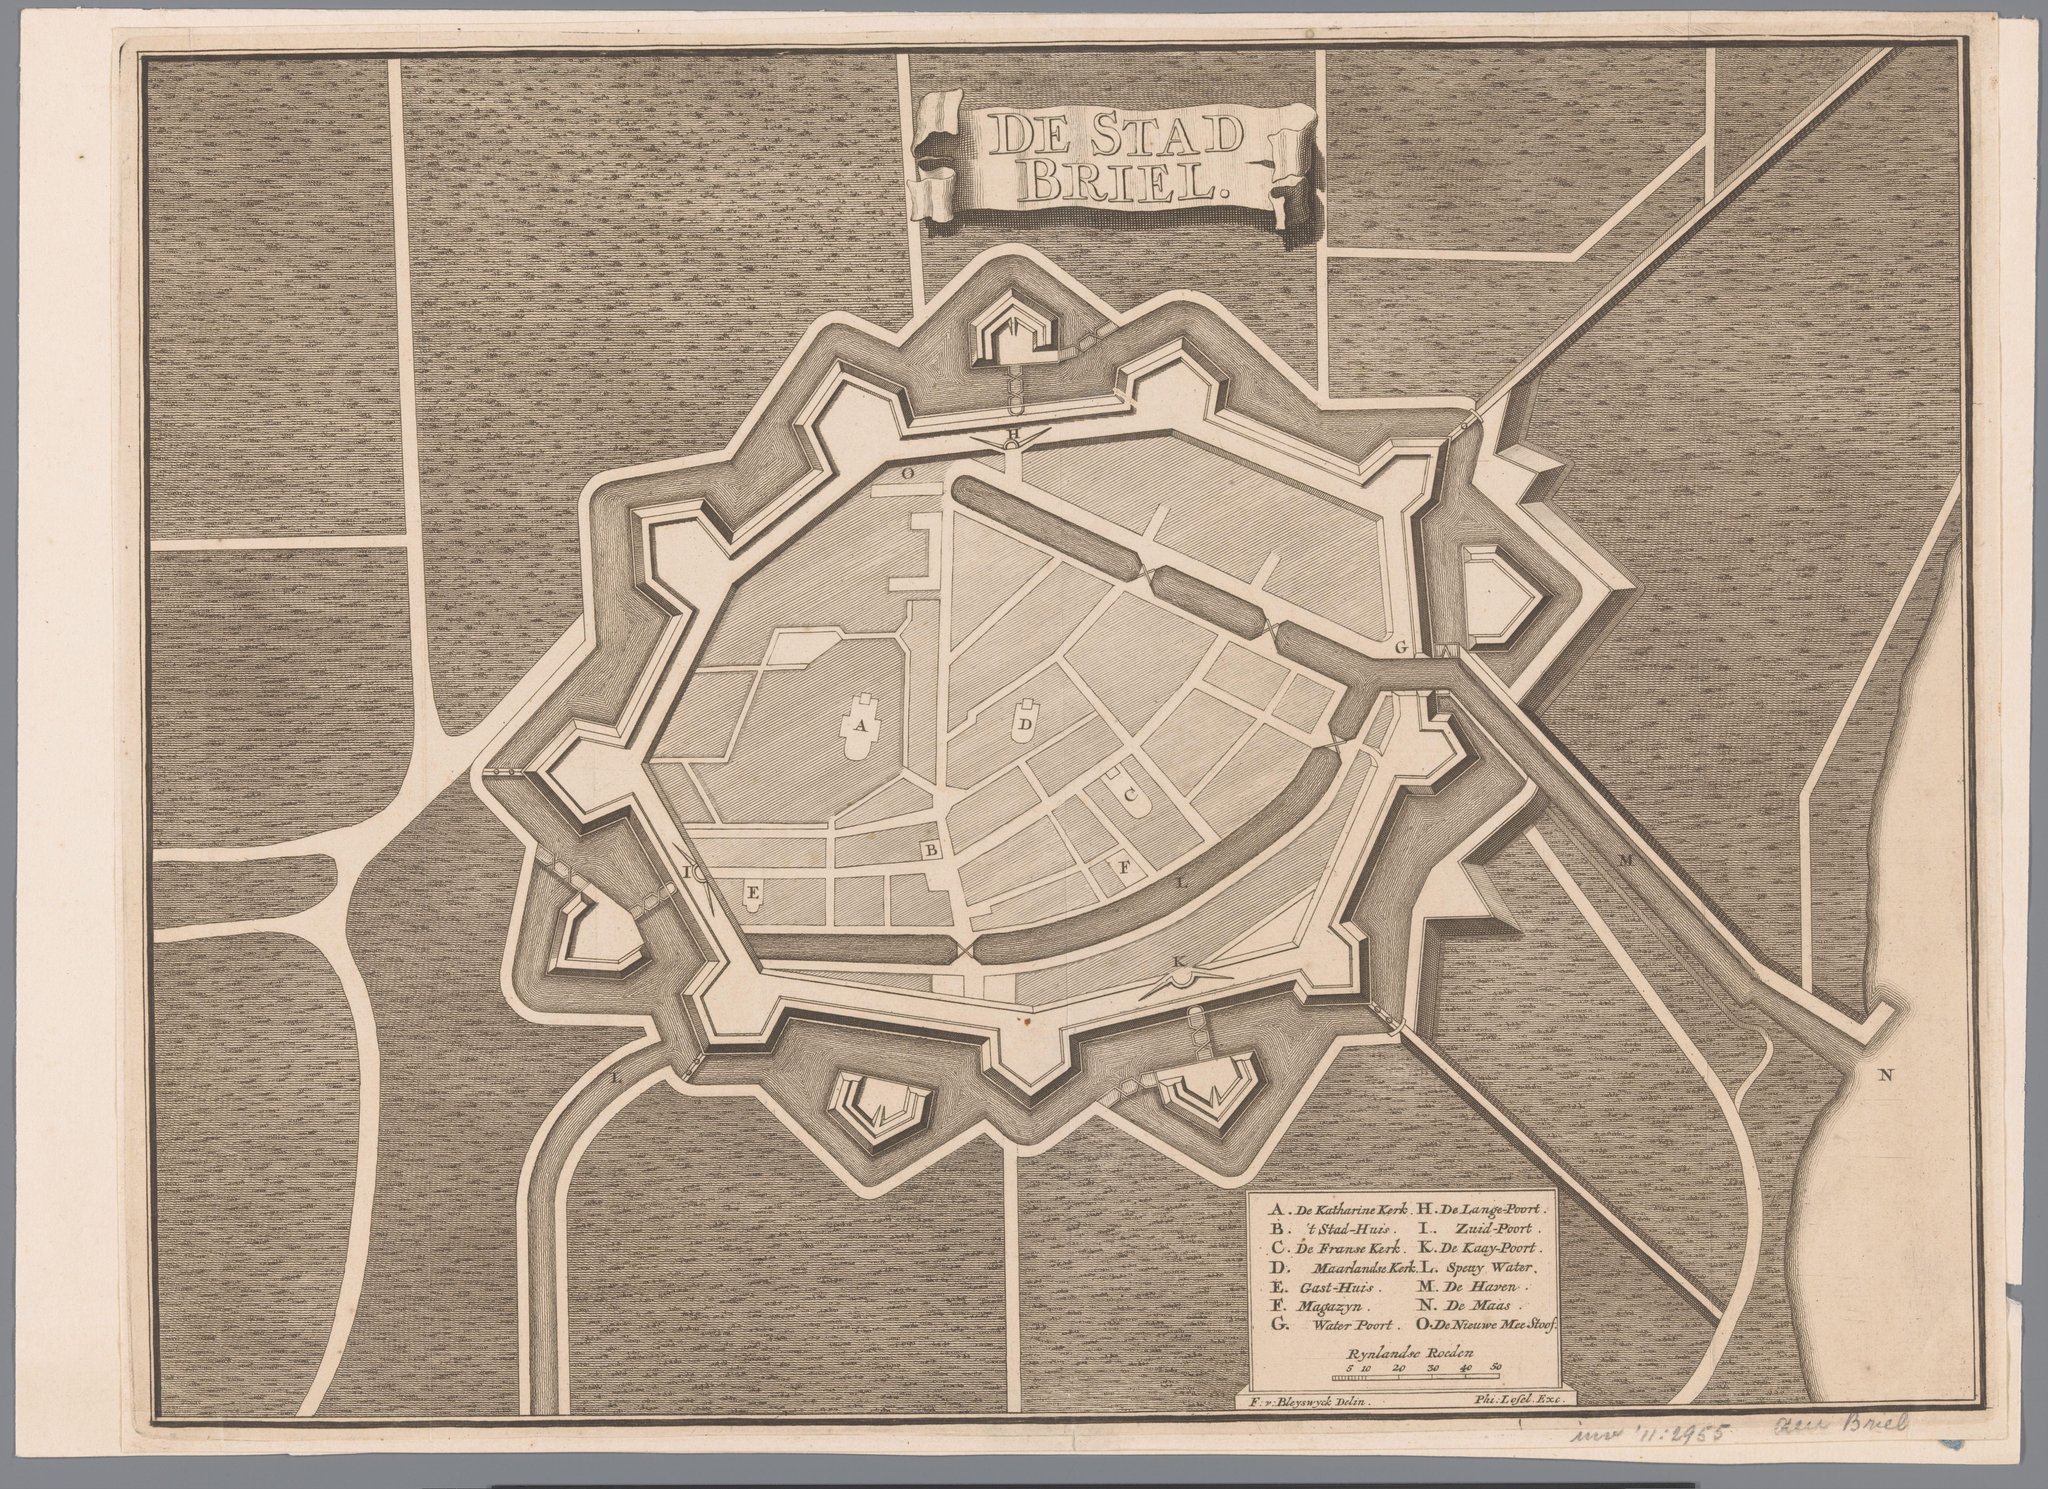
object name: area plan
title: Vestingplattegrond van Brielle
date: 1729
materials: paper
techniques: etching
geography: netherlands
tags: fortified city, maps of cities, brielle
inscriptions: collector's mark: Lugt 2228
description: Prent uit: Alkemade, Cornelis van, en Pieter van der Schelling. Beschryving van de Stad Brielle, en den lande van Voorn (…). Rotterdam: Philippus Losel, 1729, voor p. 1.